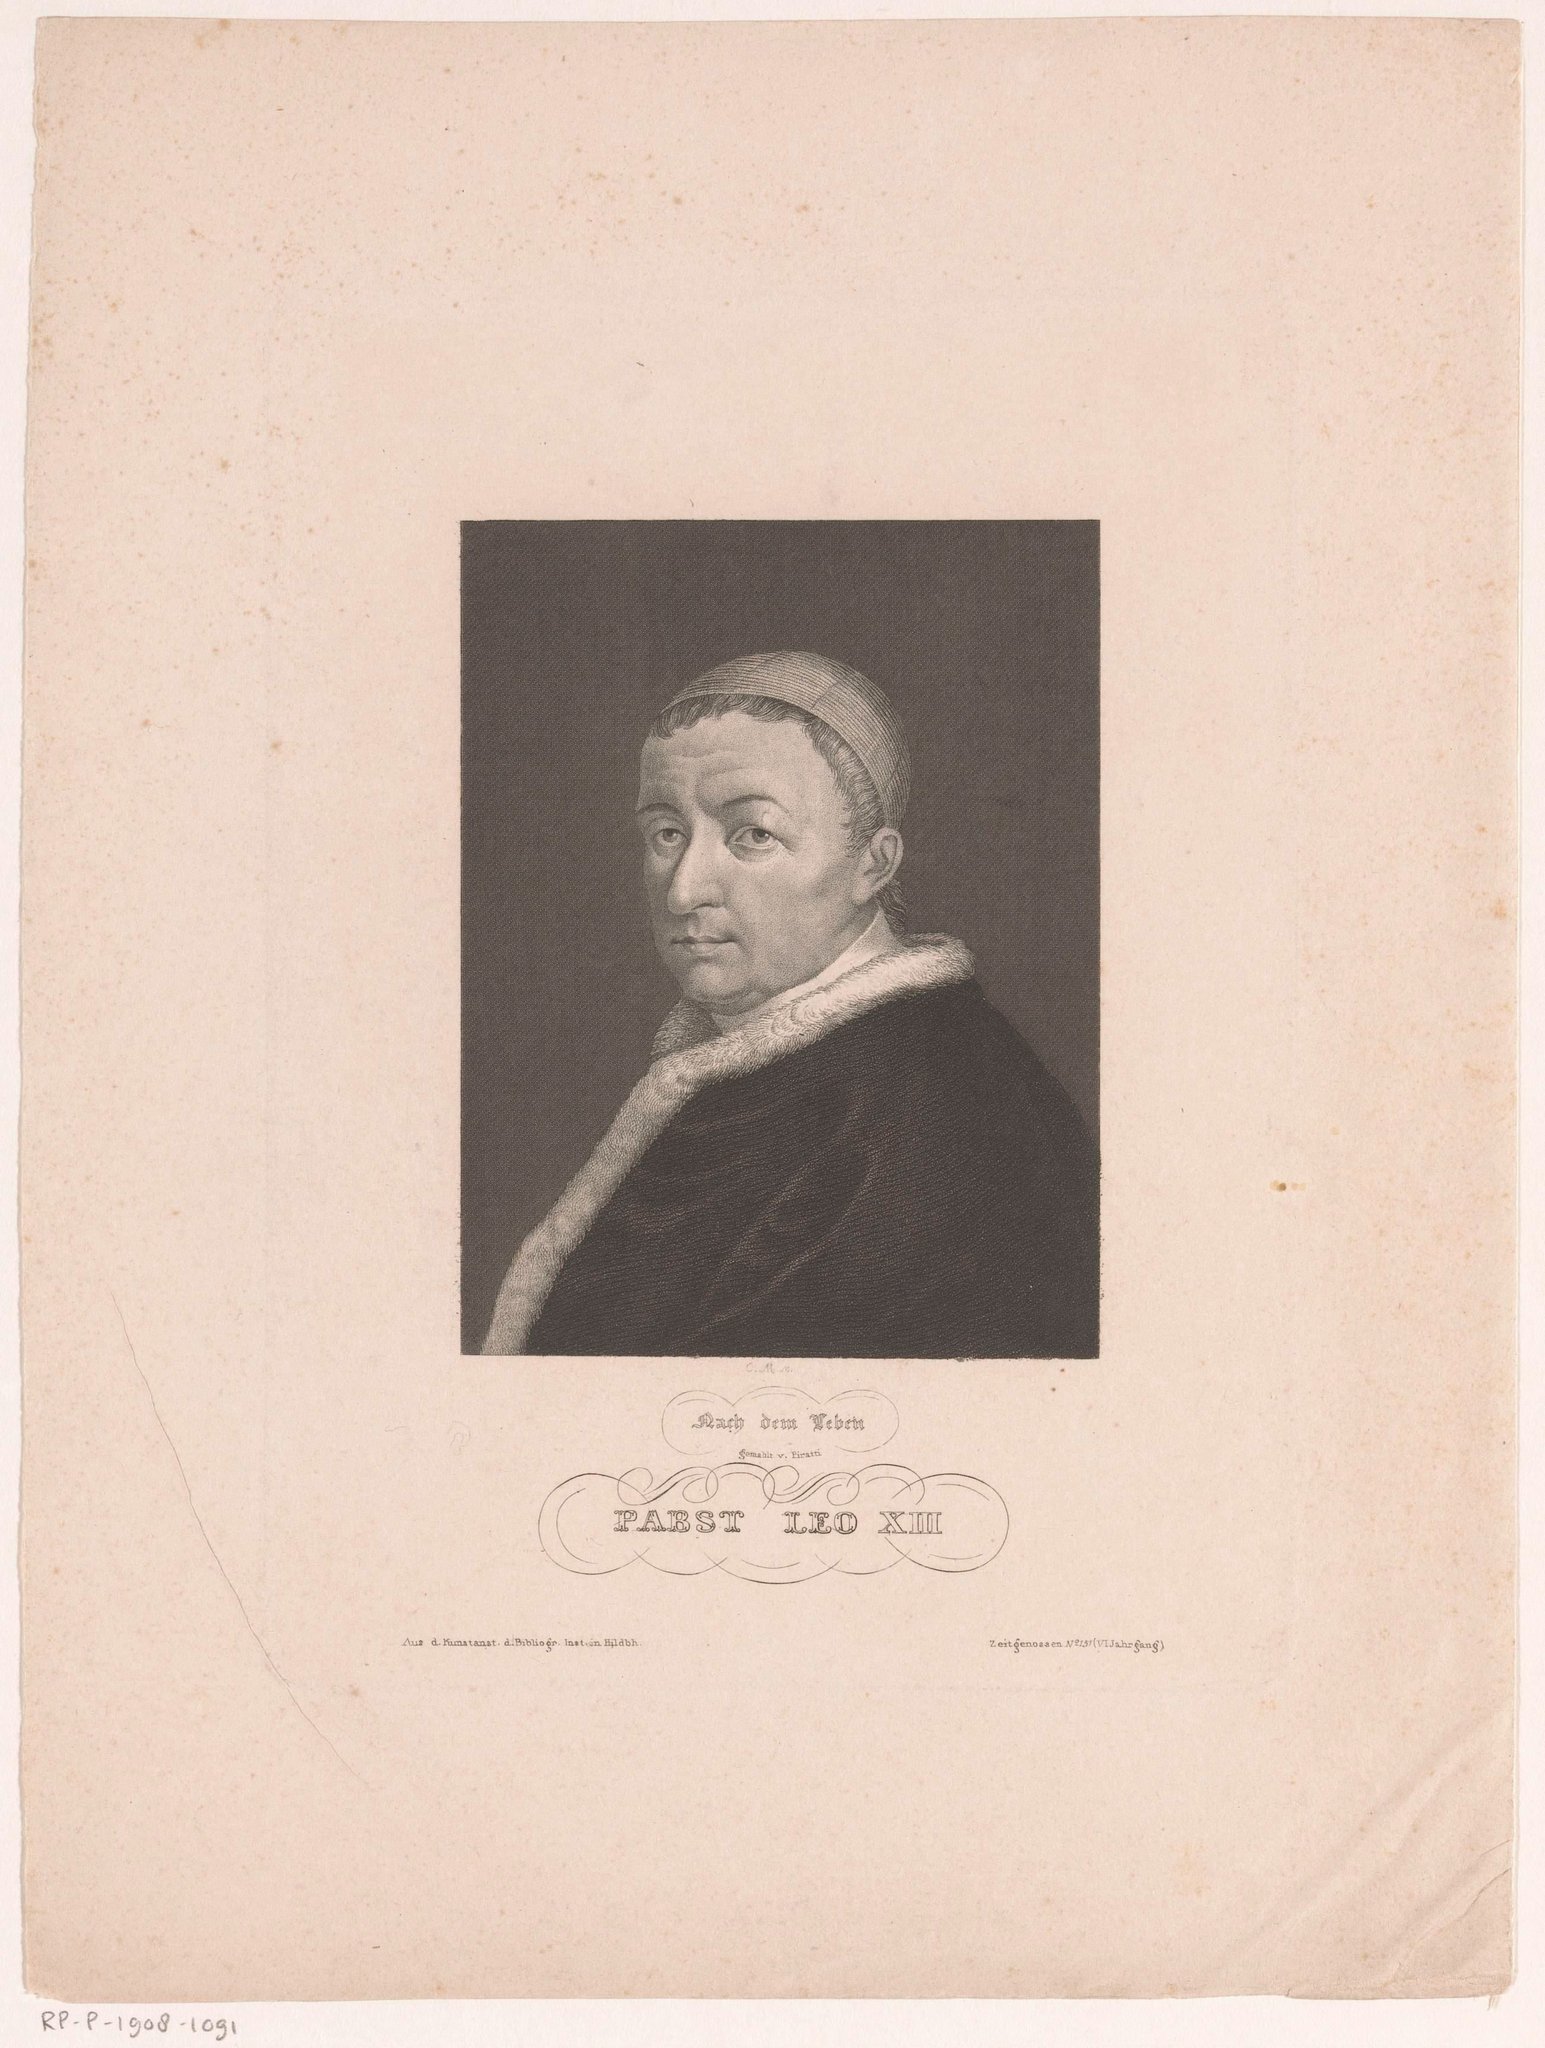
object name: print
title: Portret van Leopold II van België, op jonge leeftijd als hertog van Brabant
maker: carl mayer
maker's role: print maker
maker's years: 1798-1868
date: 1835-1865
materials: paper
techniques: engraving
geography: nuremberg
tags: brussels, laeken, leopold ii (koning der belgen), knighthood order, historical persons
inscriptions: collector's mark: Lugt 2228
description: Prent mogelijk afkomstig uit de Almanach de Gotha.